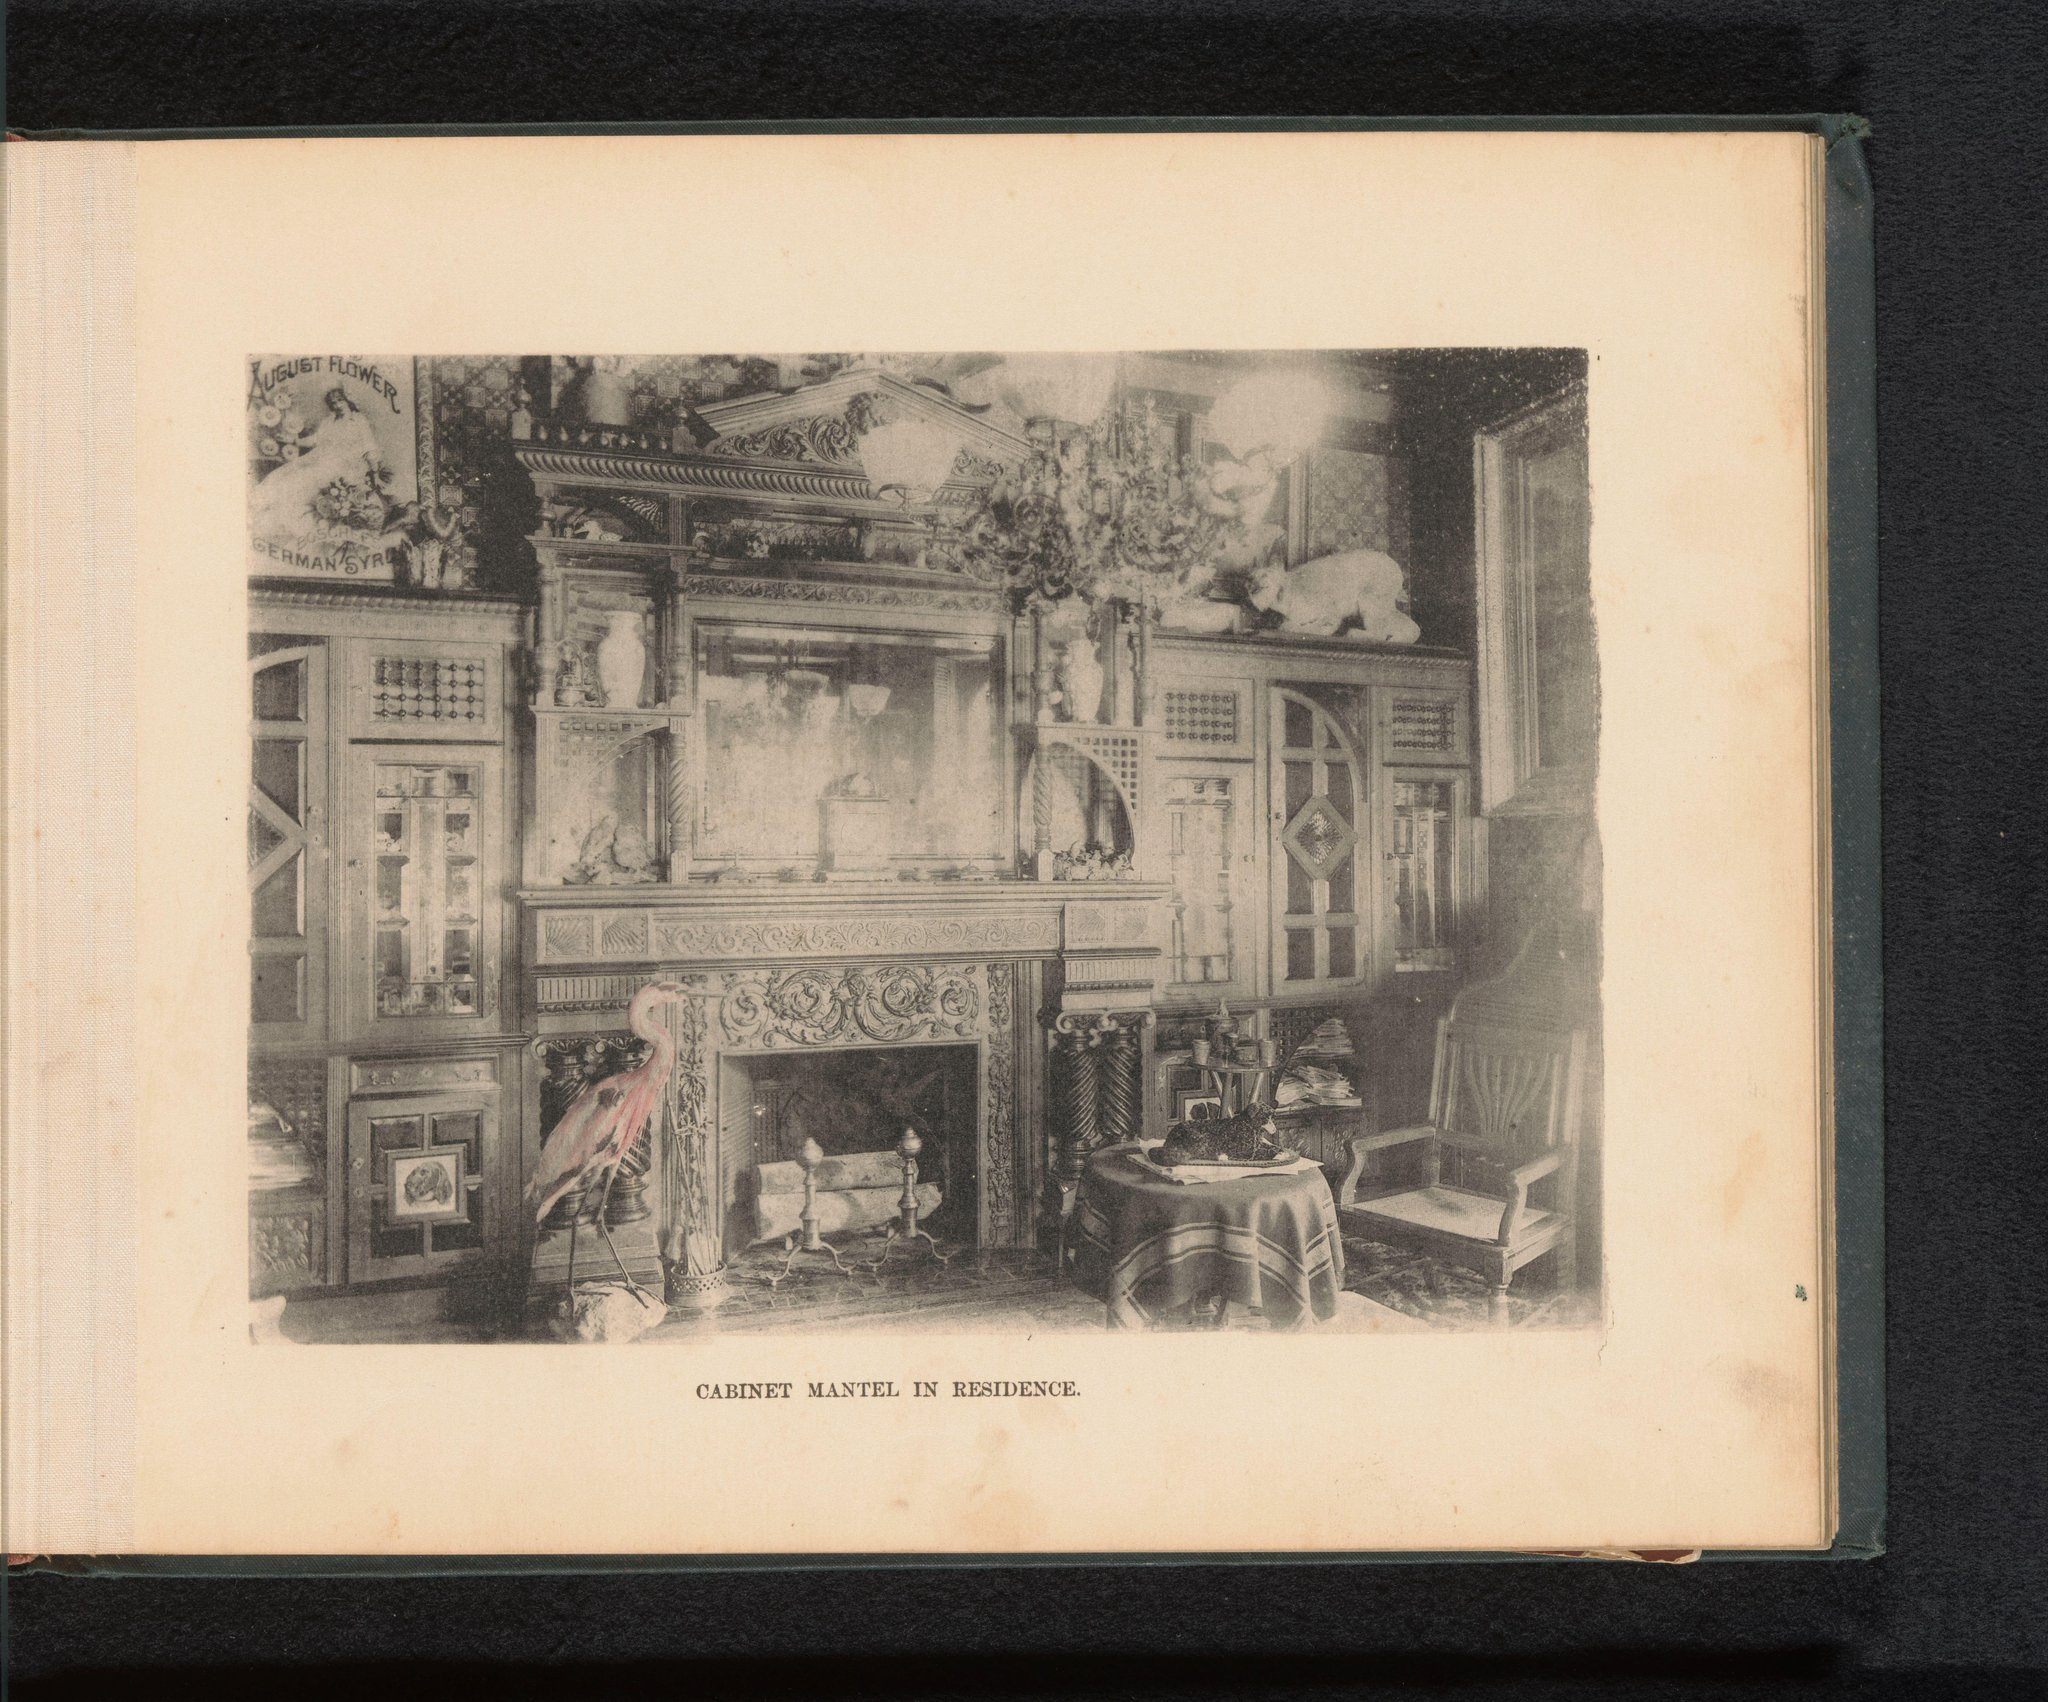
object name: page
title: Cabinet mantel in Residence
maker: Anonymous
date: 1879-1889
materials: paper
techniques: photograph, hand coloring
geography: woodbury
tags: interior of the house, villa, chimney-piece, mantelpiece